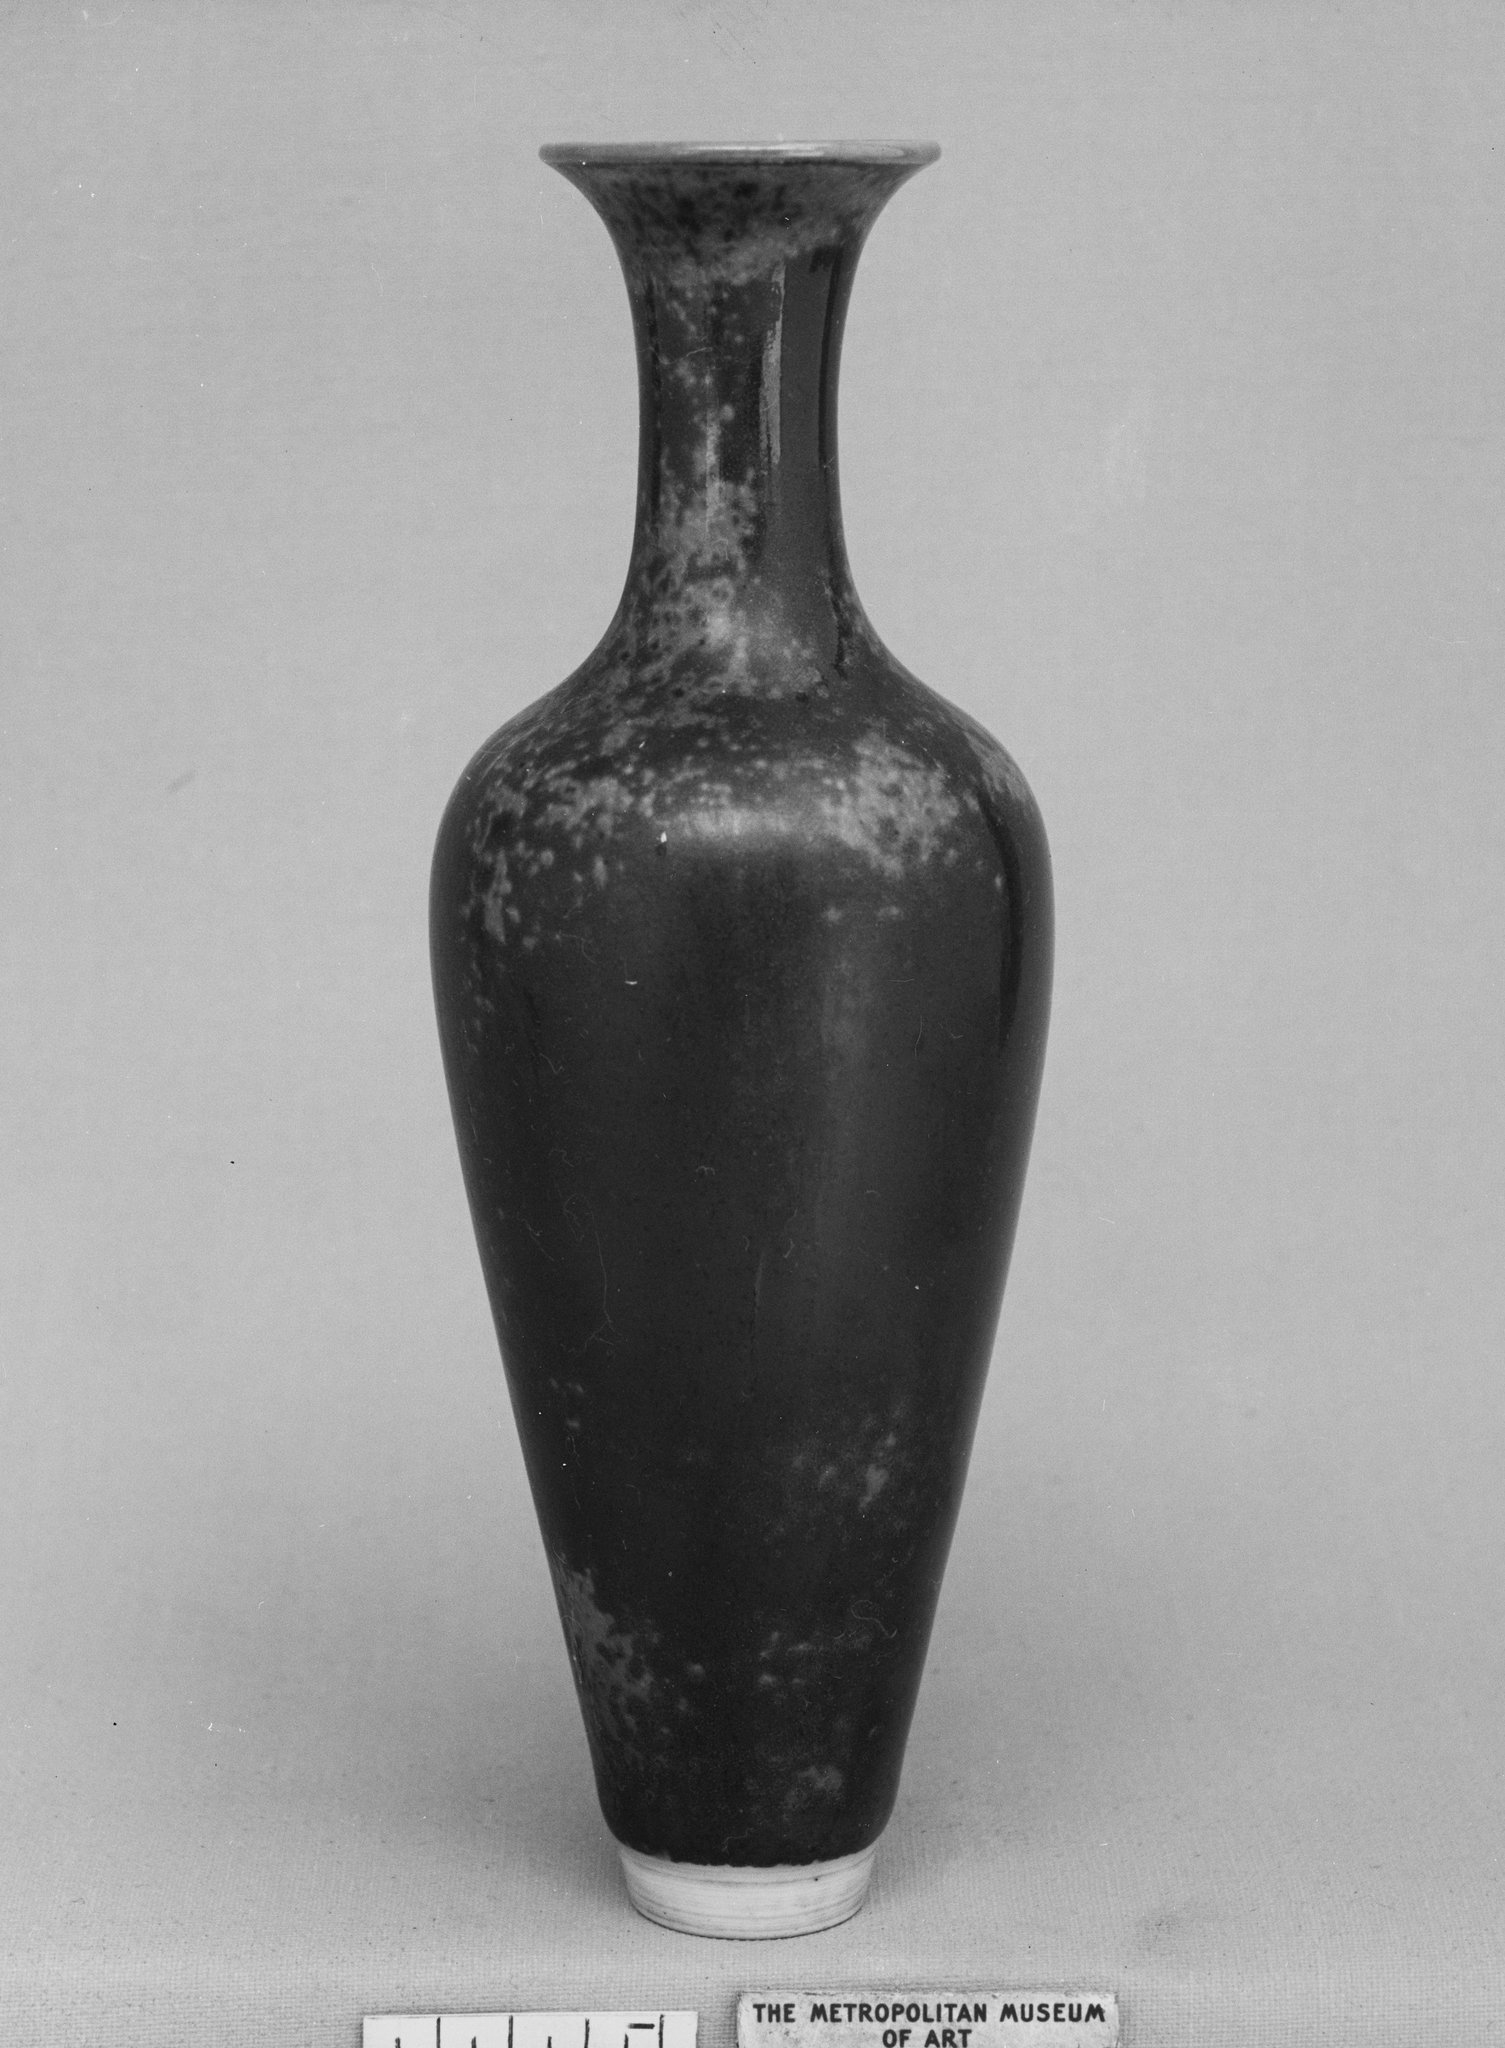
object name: vase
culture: chinese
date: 1662-1722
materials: porcelain